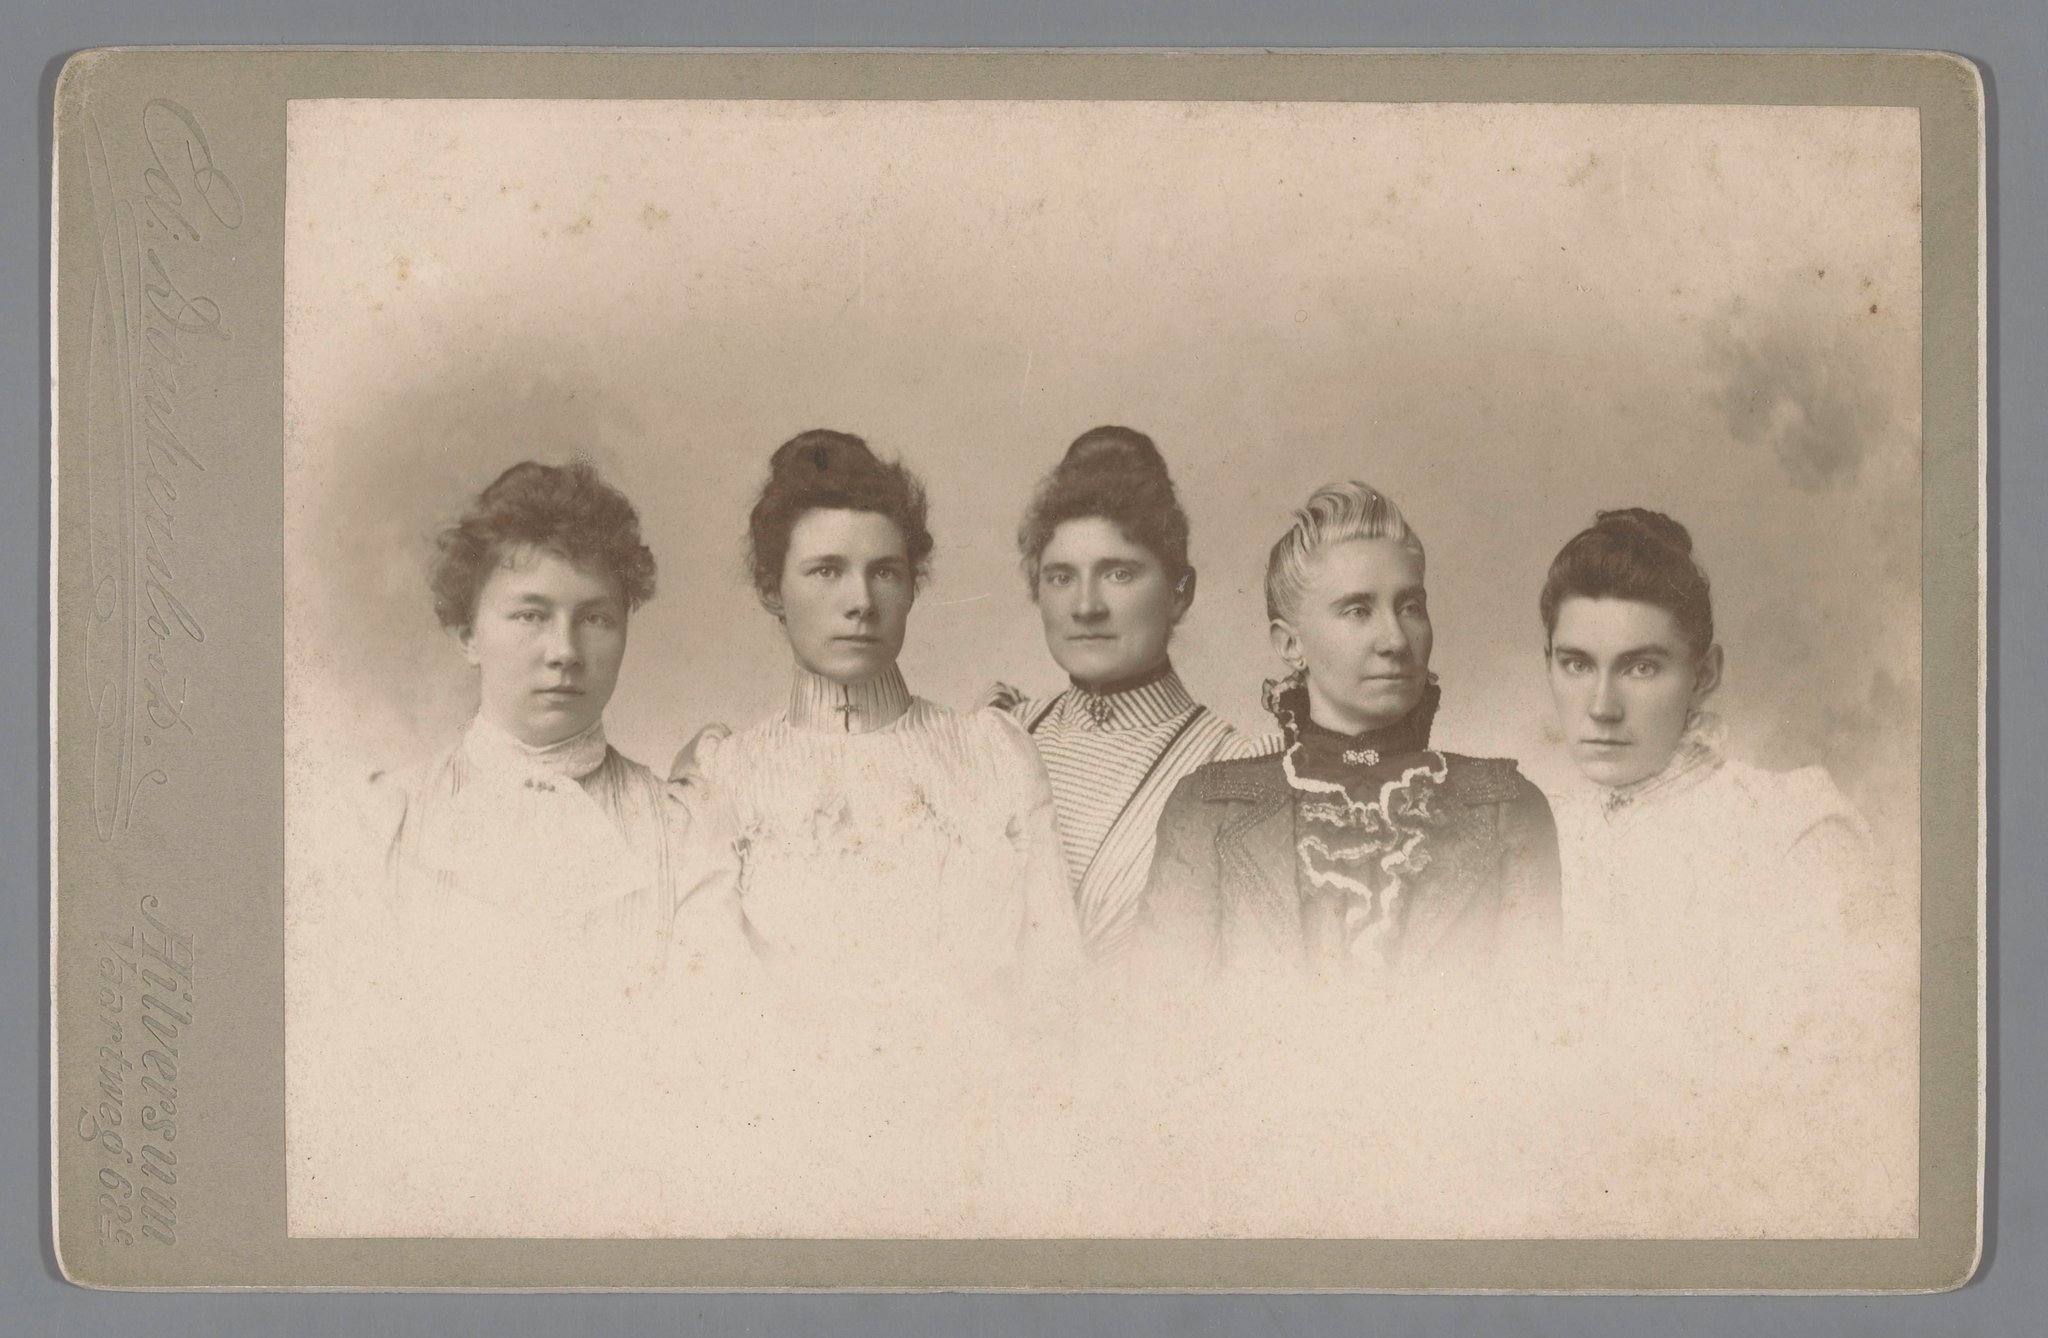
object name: cabinet photograph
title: Portret van vijf onbekende vrouwen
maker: eduard donkersloot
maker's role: fotograaf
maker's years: 1860-1907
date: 1894-1907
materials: cardboard, photographic support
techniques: gelatin silver print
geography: hilversum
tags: adult woman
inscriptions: name: ‘Ed. Donkersloot Hilversum Vaartweg 68c.’